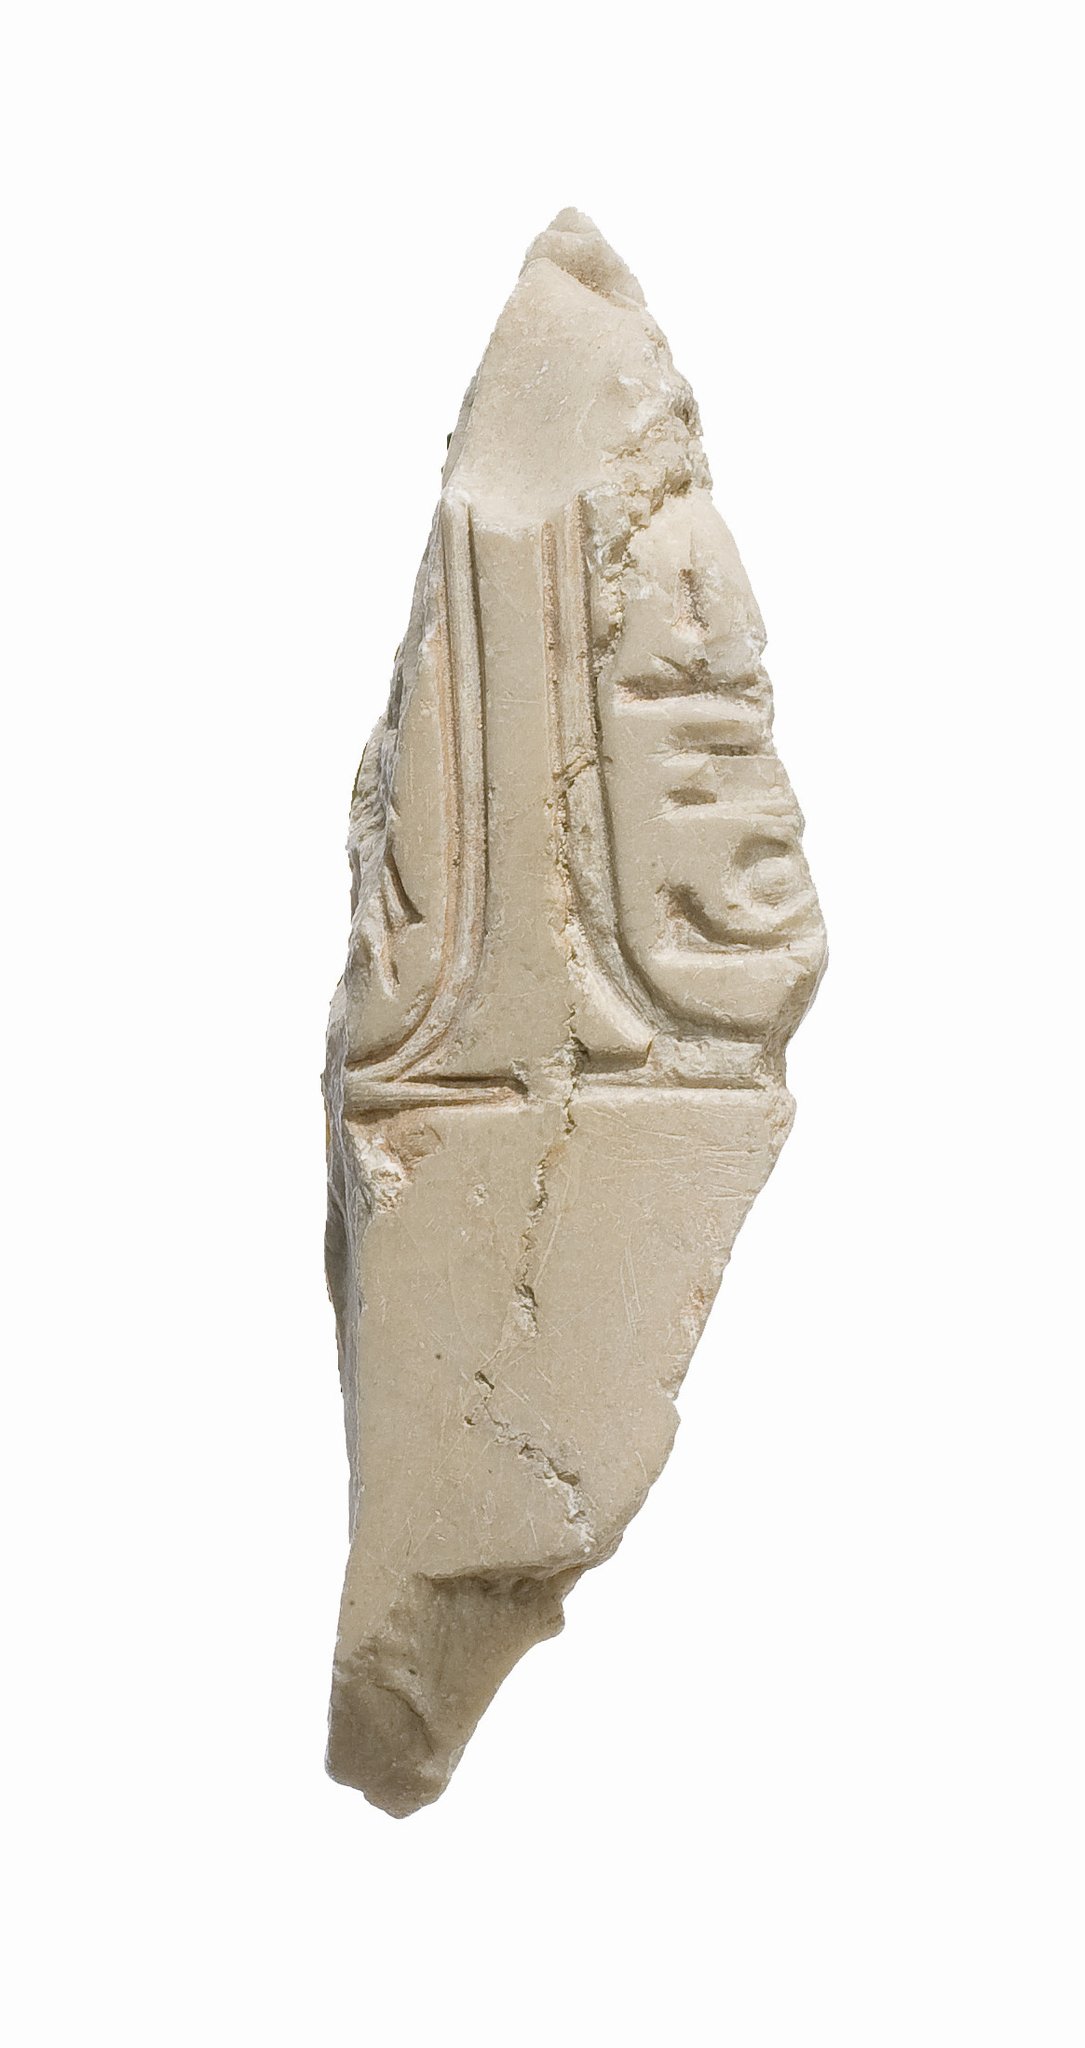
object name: miscellany, aten cartouche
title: Miscellaneous fragment, Aten cartouche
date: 1353-1336 BCE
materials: limestone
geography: egypt